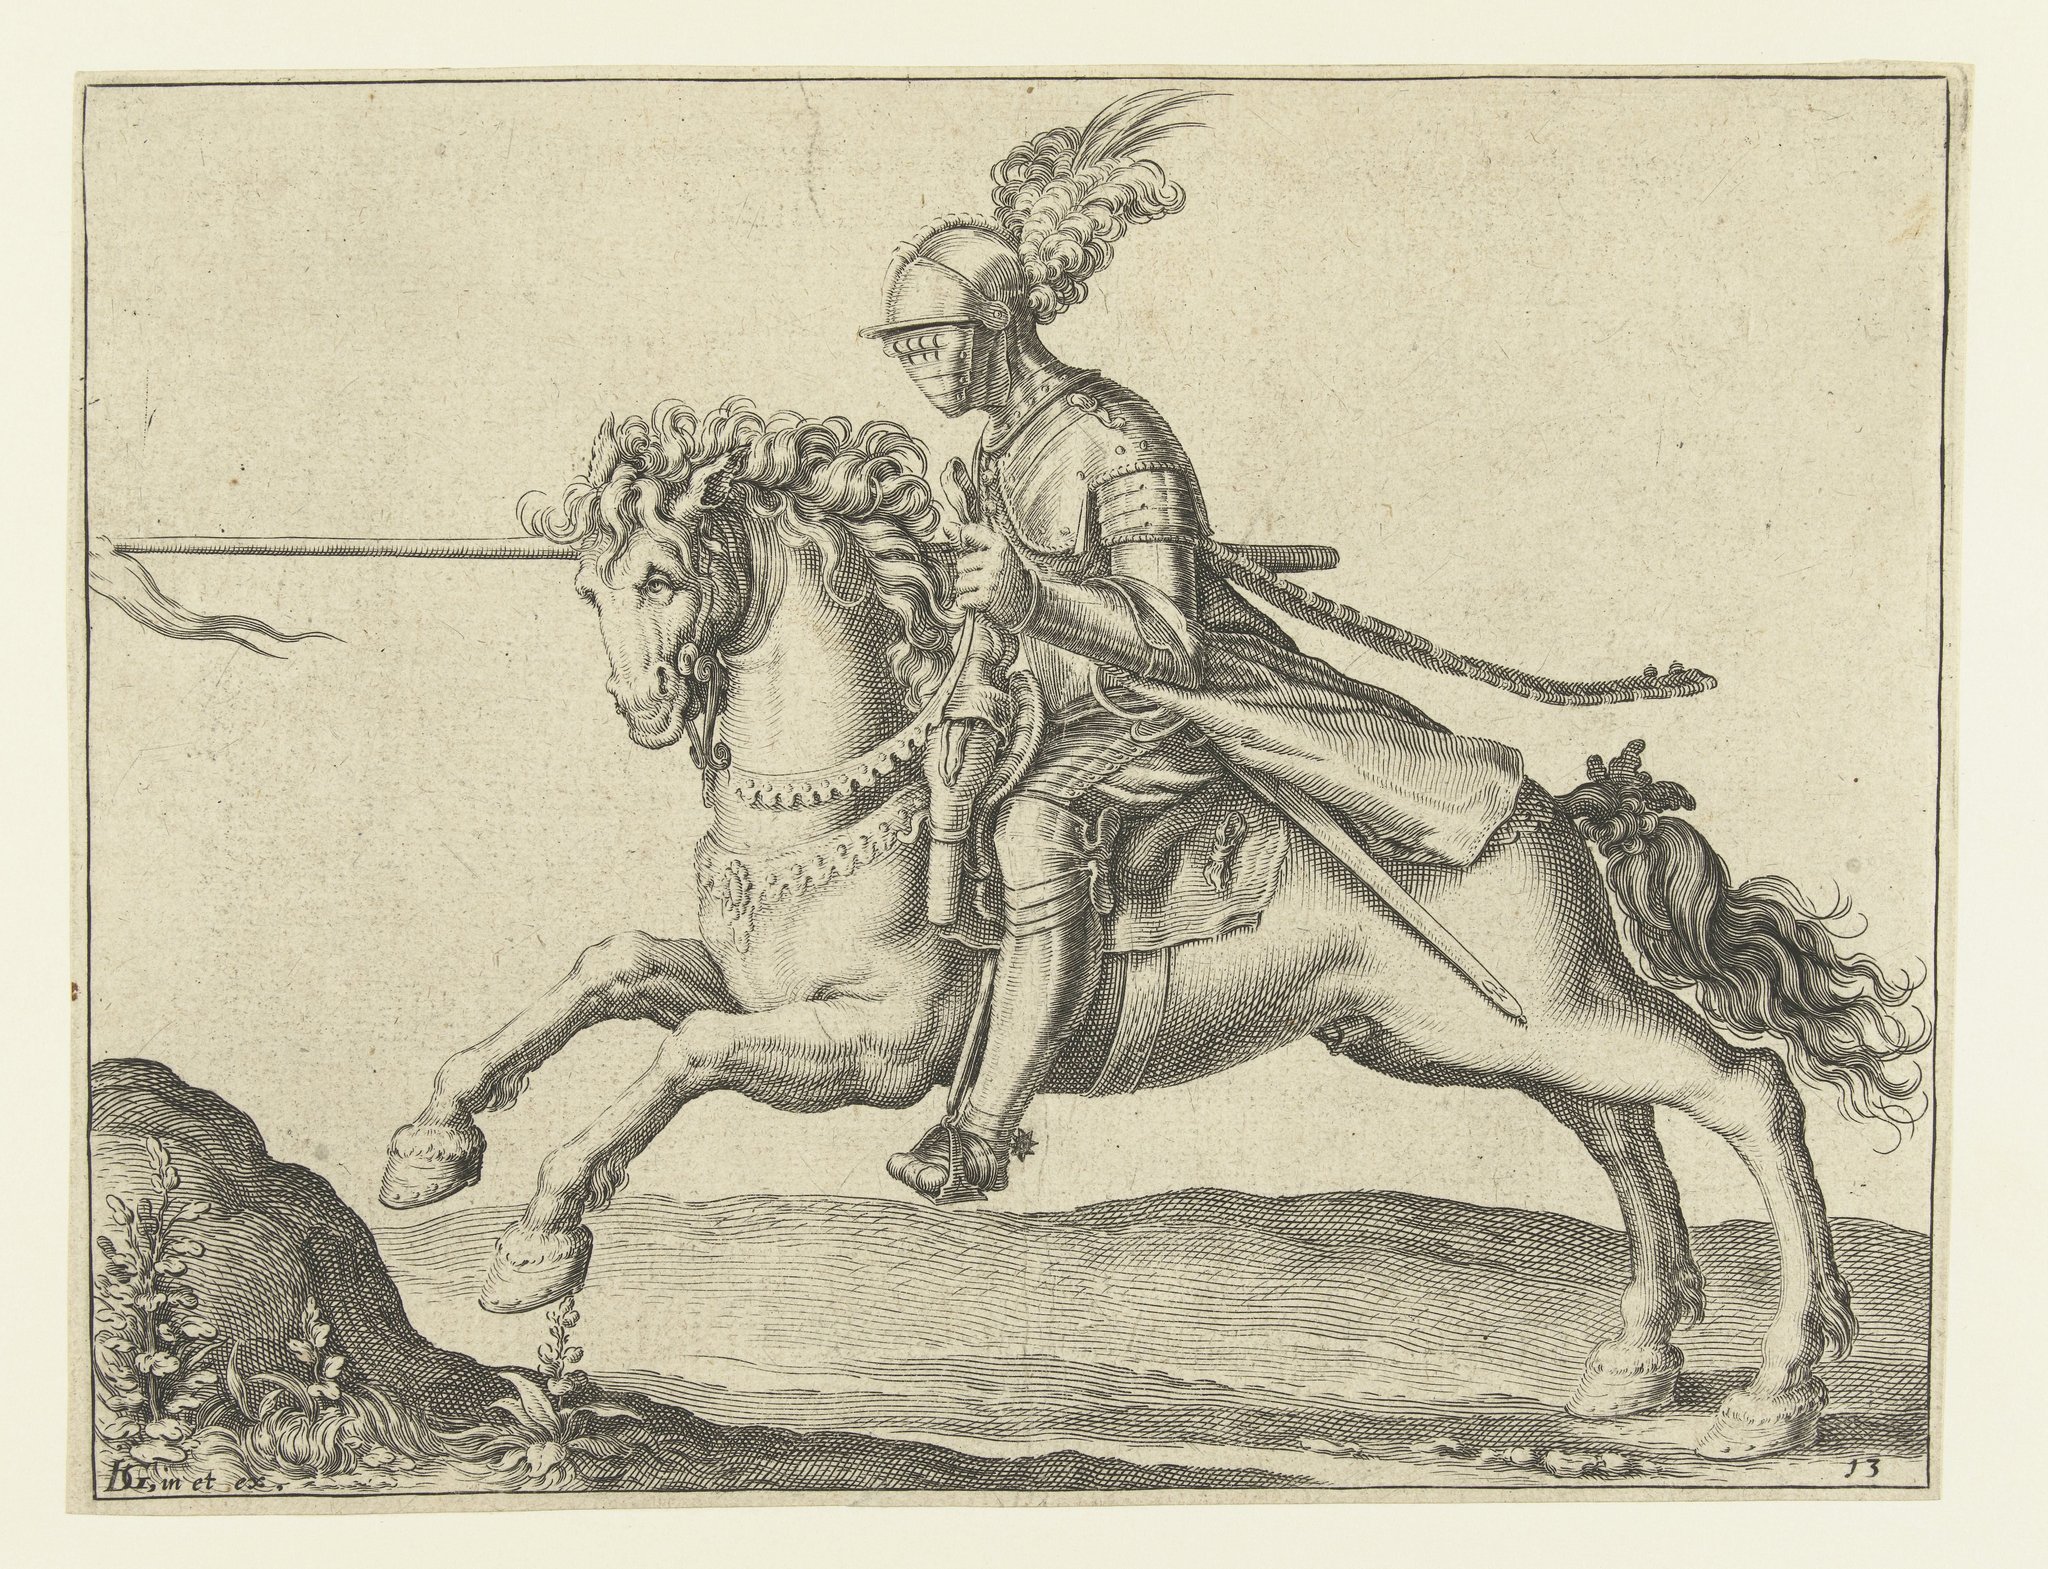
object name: print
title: De ruiterschool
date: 1599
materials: paper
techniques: engraving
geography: netherlands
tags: helved weapons, polearms (for striking, hacking, thrusting): lance, warfare; military affairs (+ cavalry, horsemen)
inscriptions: collector's mark: Lugt 2228a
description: Een geharnaste man te paard (speerruiter) rijdt in aanvallende houding, met vooruitgestoken lans, naar links. Deze prent is onderdeel van een serie van 22 genummerde prenten: een titelprent, 20 prenten waarop één of enkele verschillende typen (meest geharnaste) ruiters zijn weergegeven, en een prent met een ruitergevecht.